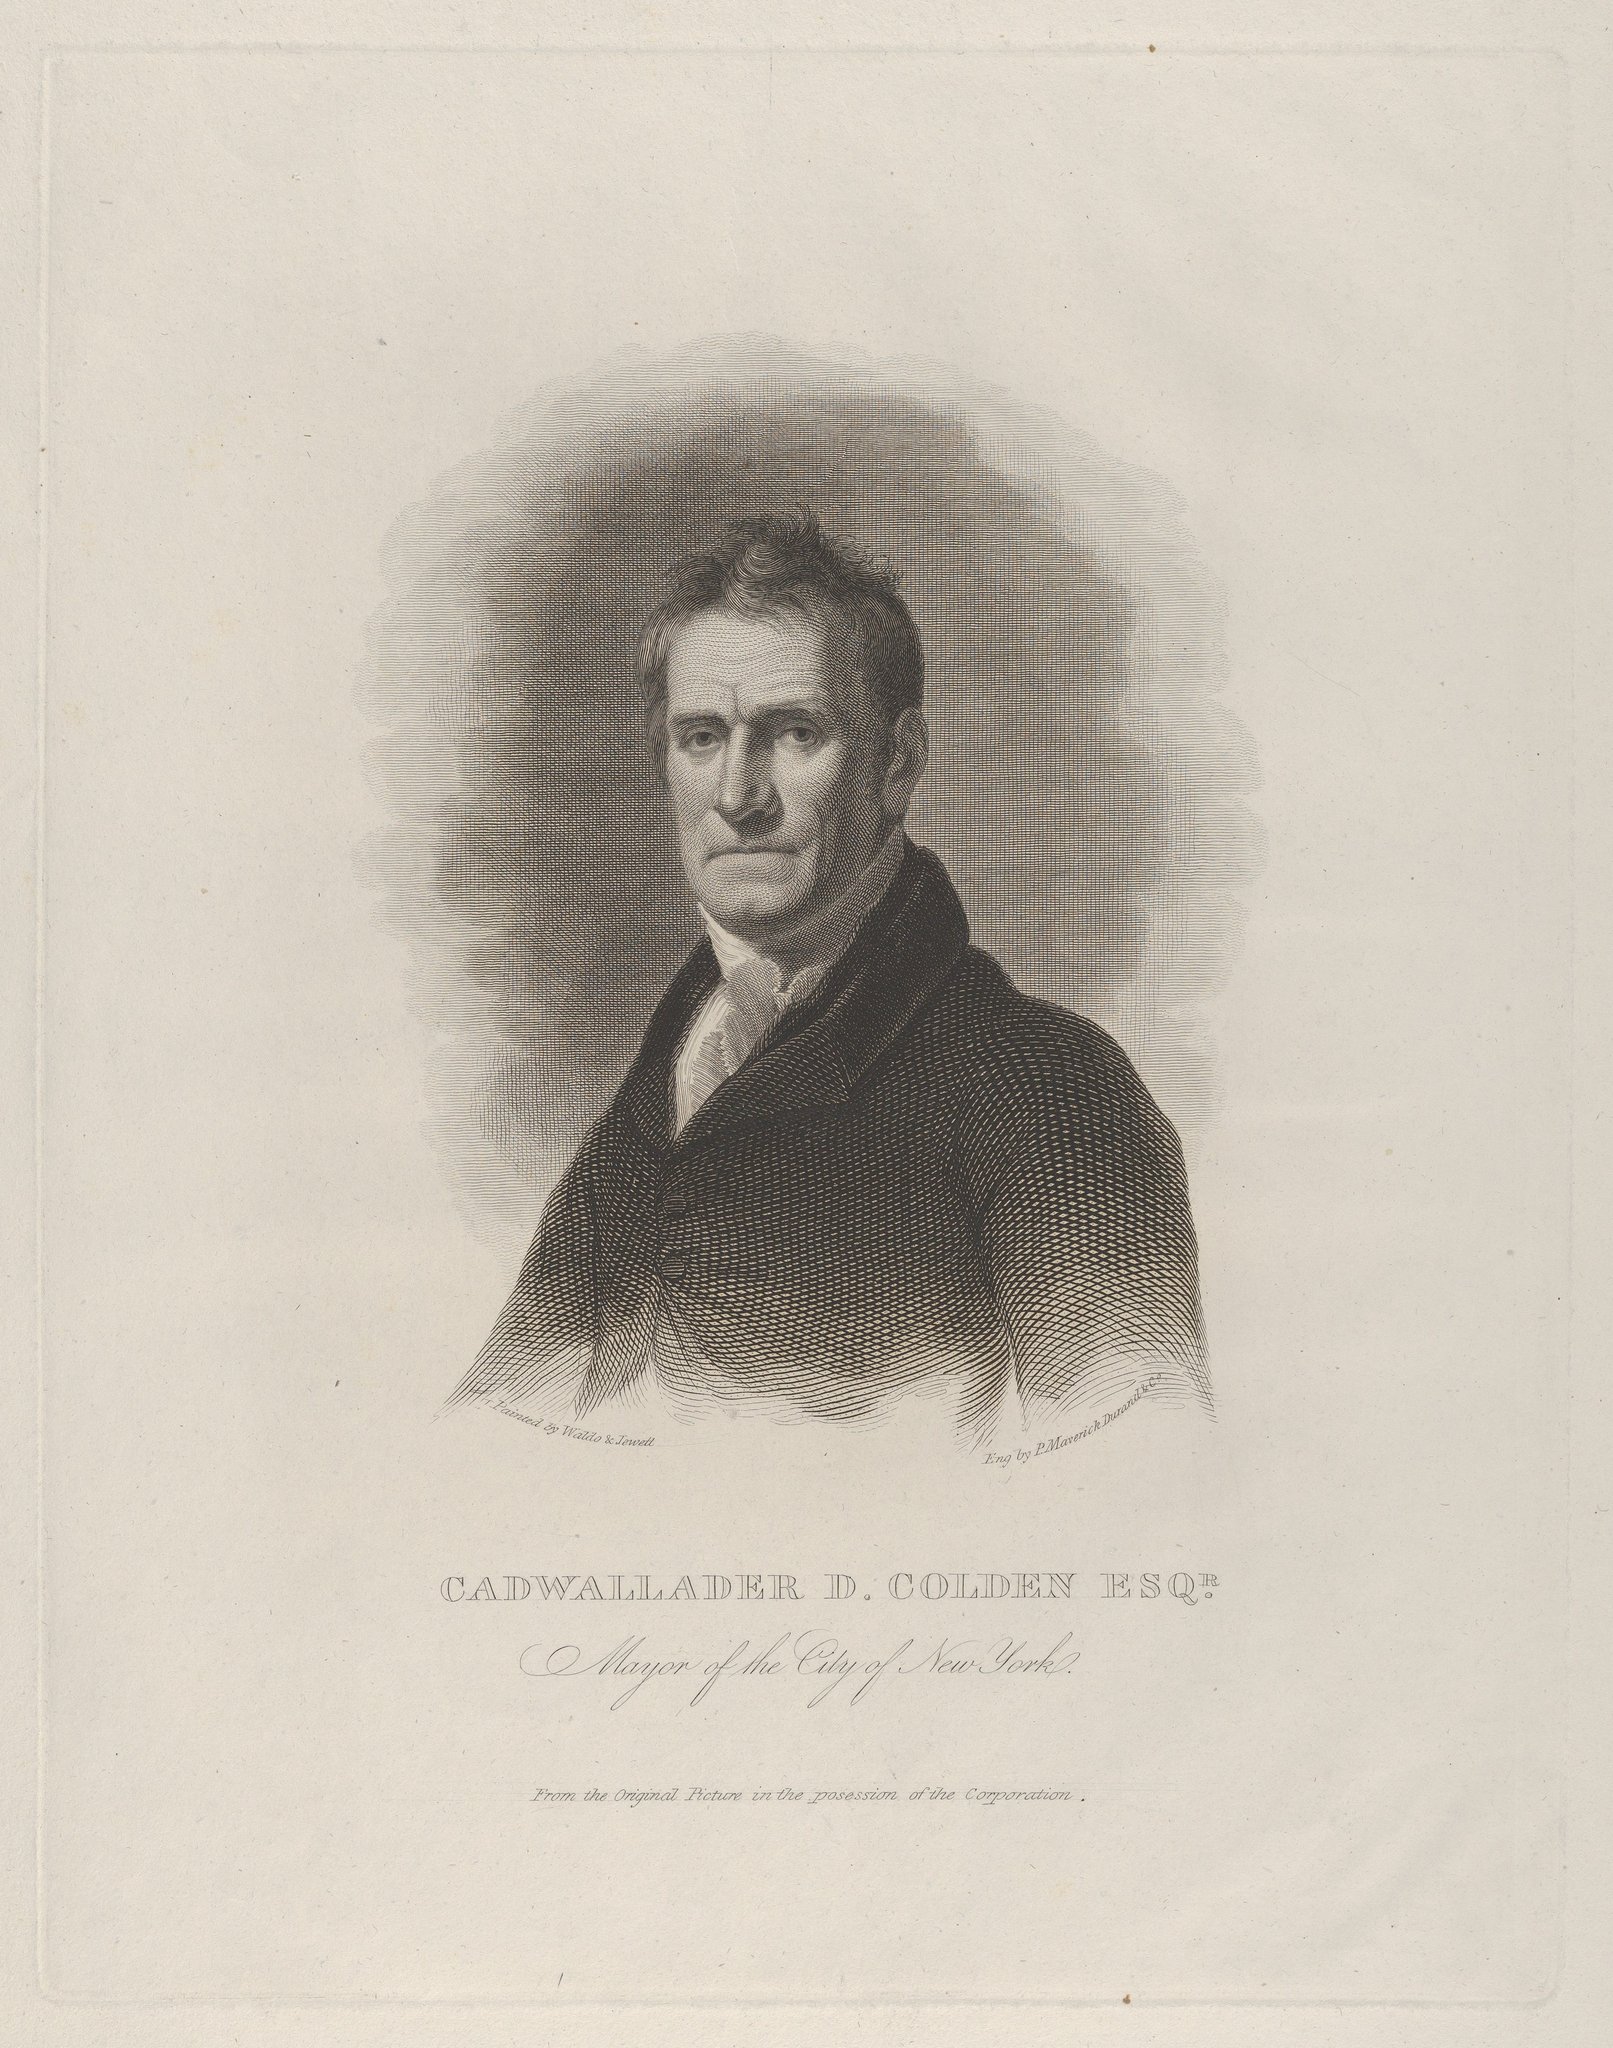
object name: print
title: Cadwallader David Colden, Mayor of New York City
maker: asher brown durand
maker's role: artist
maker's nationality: american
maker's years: 1796-1886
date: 1825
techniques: engraving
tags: men,portraits